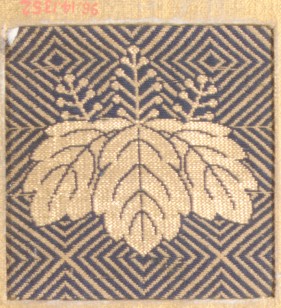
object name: piece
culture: japanese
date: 1701-1900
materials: silk